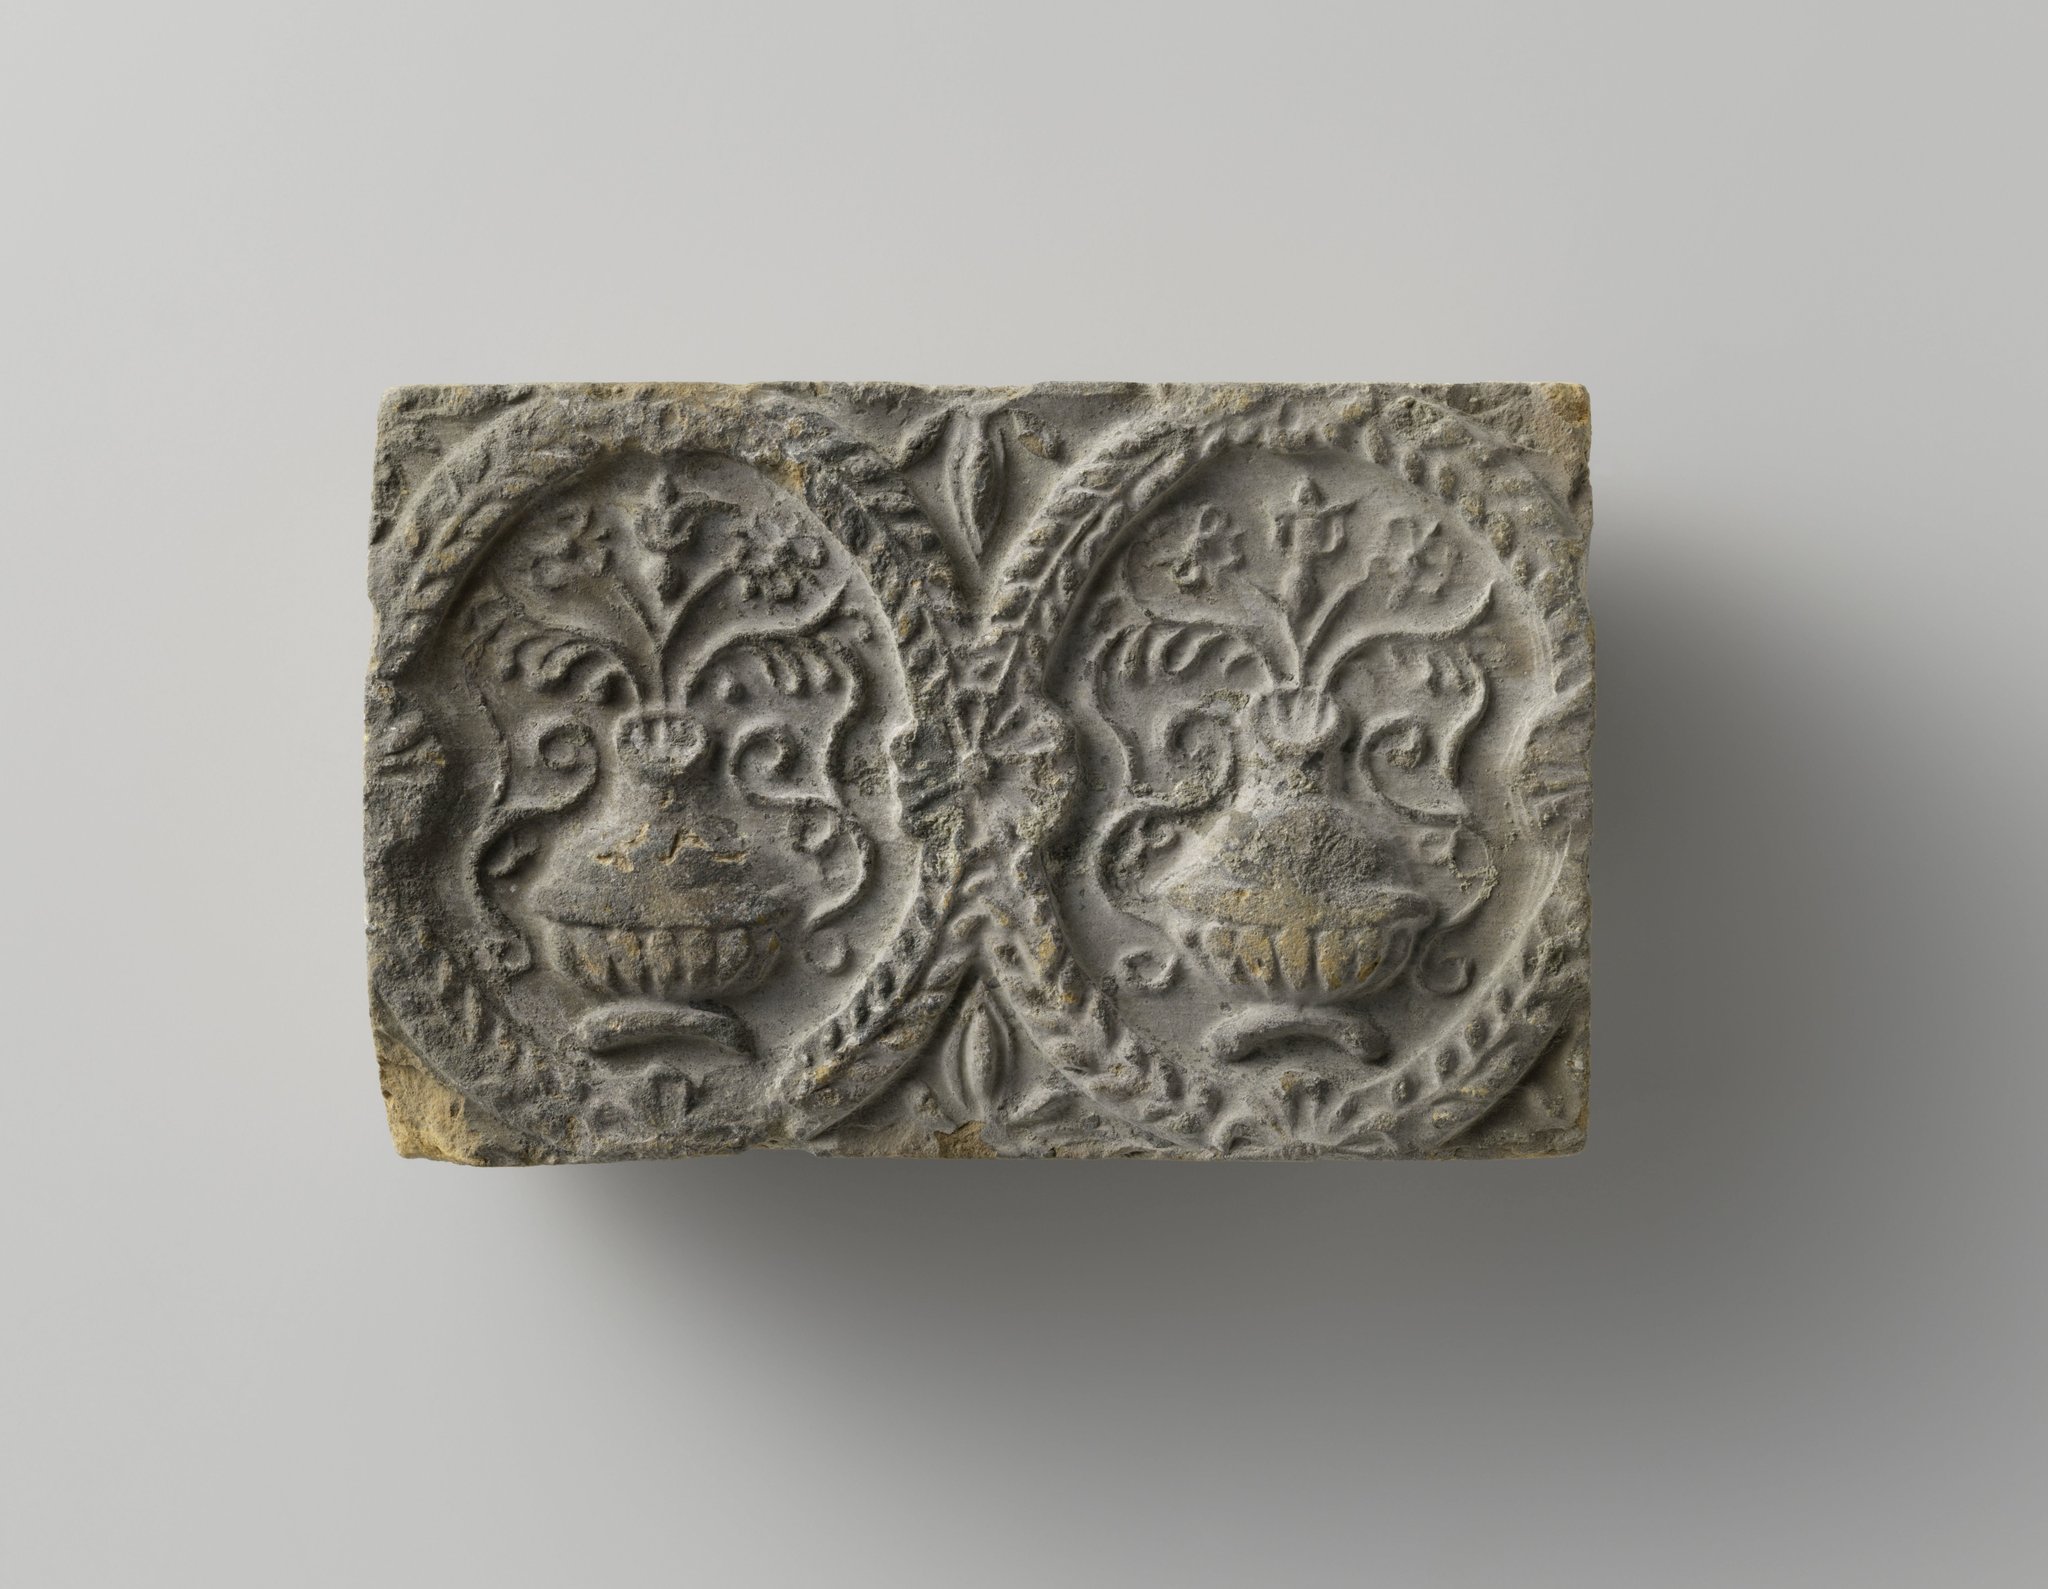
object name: architectural element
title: Haardsteen met een voorstelling van twee bloemenvazen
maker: Anonymous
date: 1600-1625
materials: earthenware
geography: southern netherlands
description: Haardsteen met een voorstelling van twee bloemenvazen, geplaatst in twee ovale lauwerkransen die door een rozet zijn verbonden.